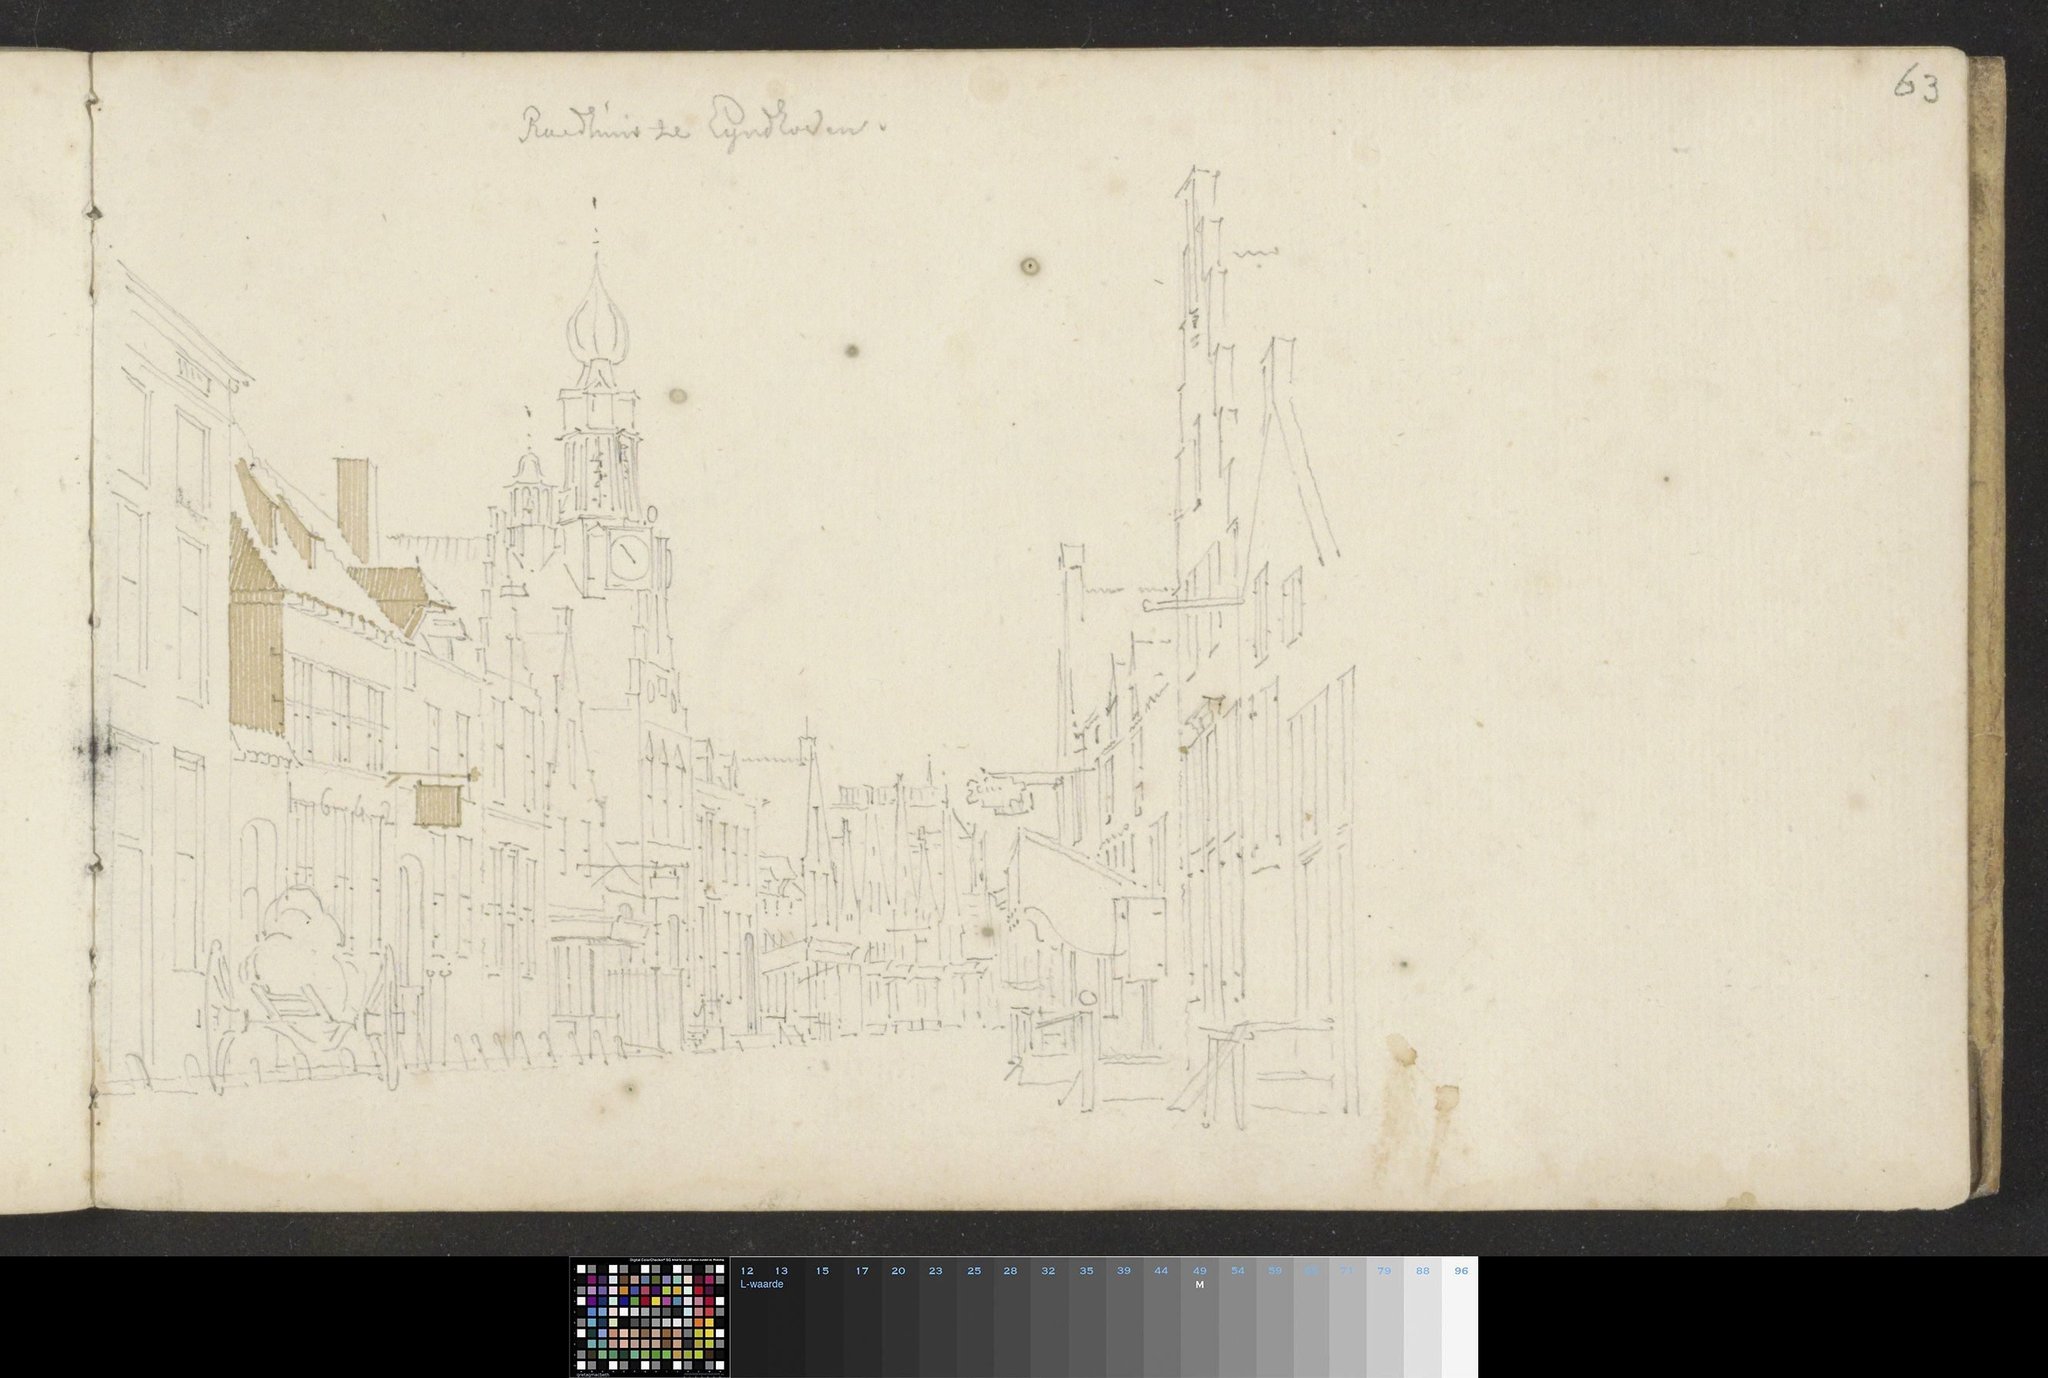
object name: sketchbook leaf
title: Gezicht te Eindhoven met het raadhuis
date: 1701-1759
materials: ink, paper, pencil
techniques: pen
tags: prospect of village, silhouette of village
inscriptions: annotation: ‘Raadhuis te Eyndhoven.’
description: Blad 63 recto uit een schetsboek met 65 bladen.